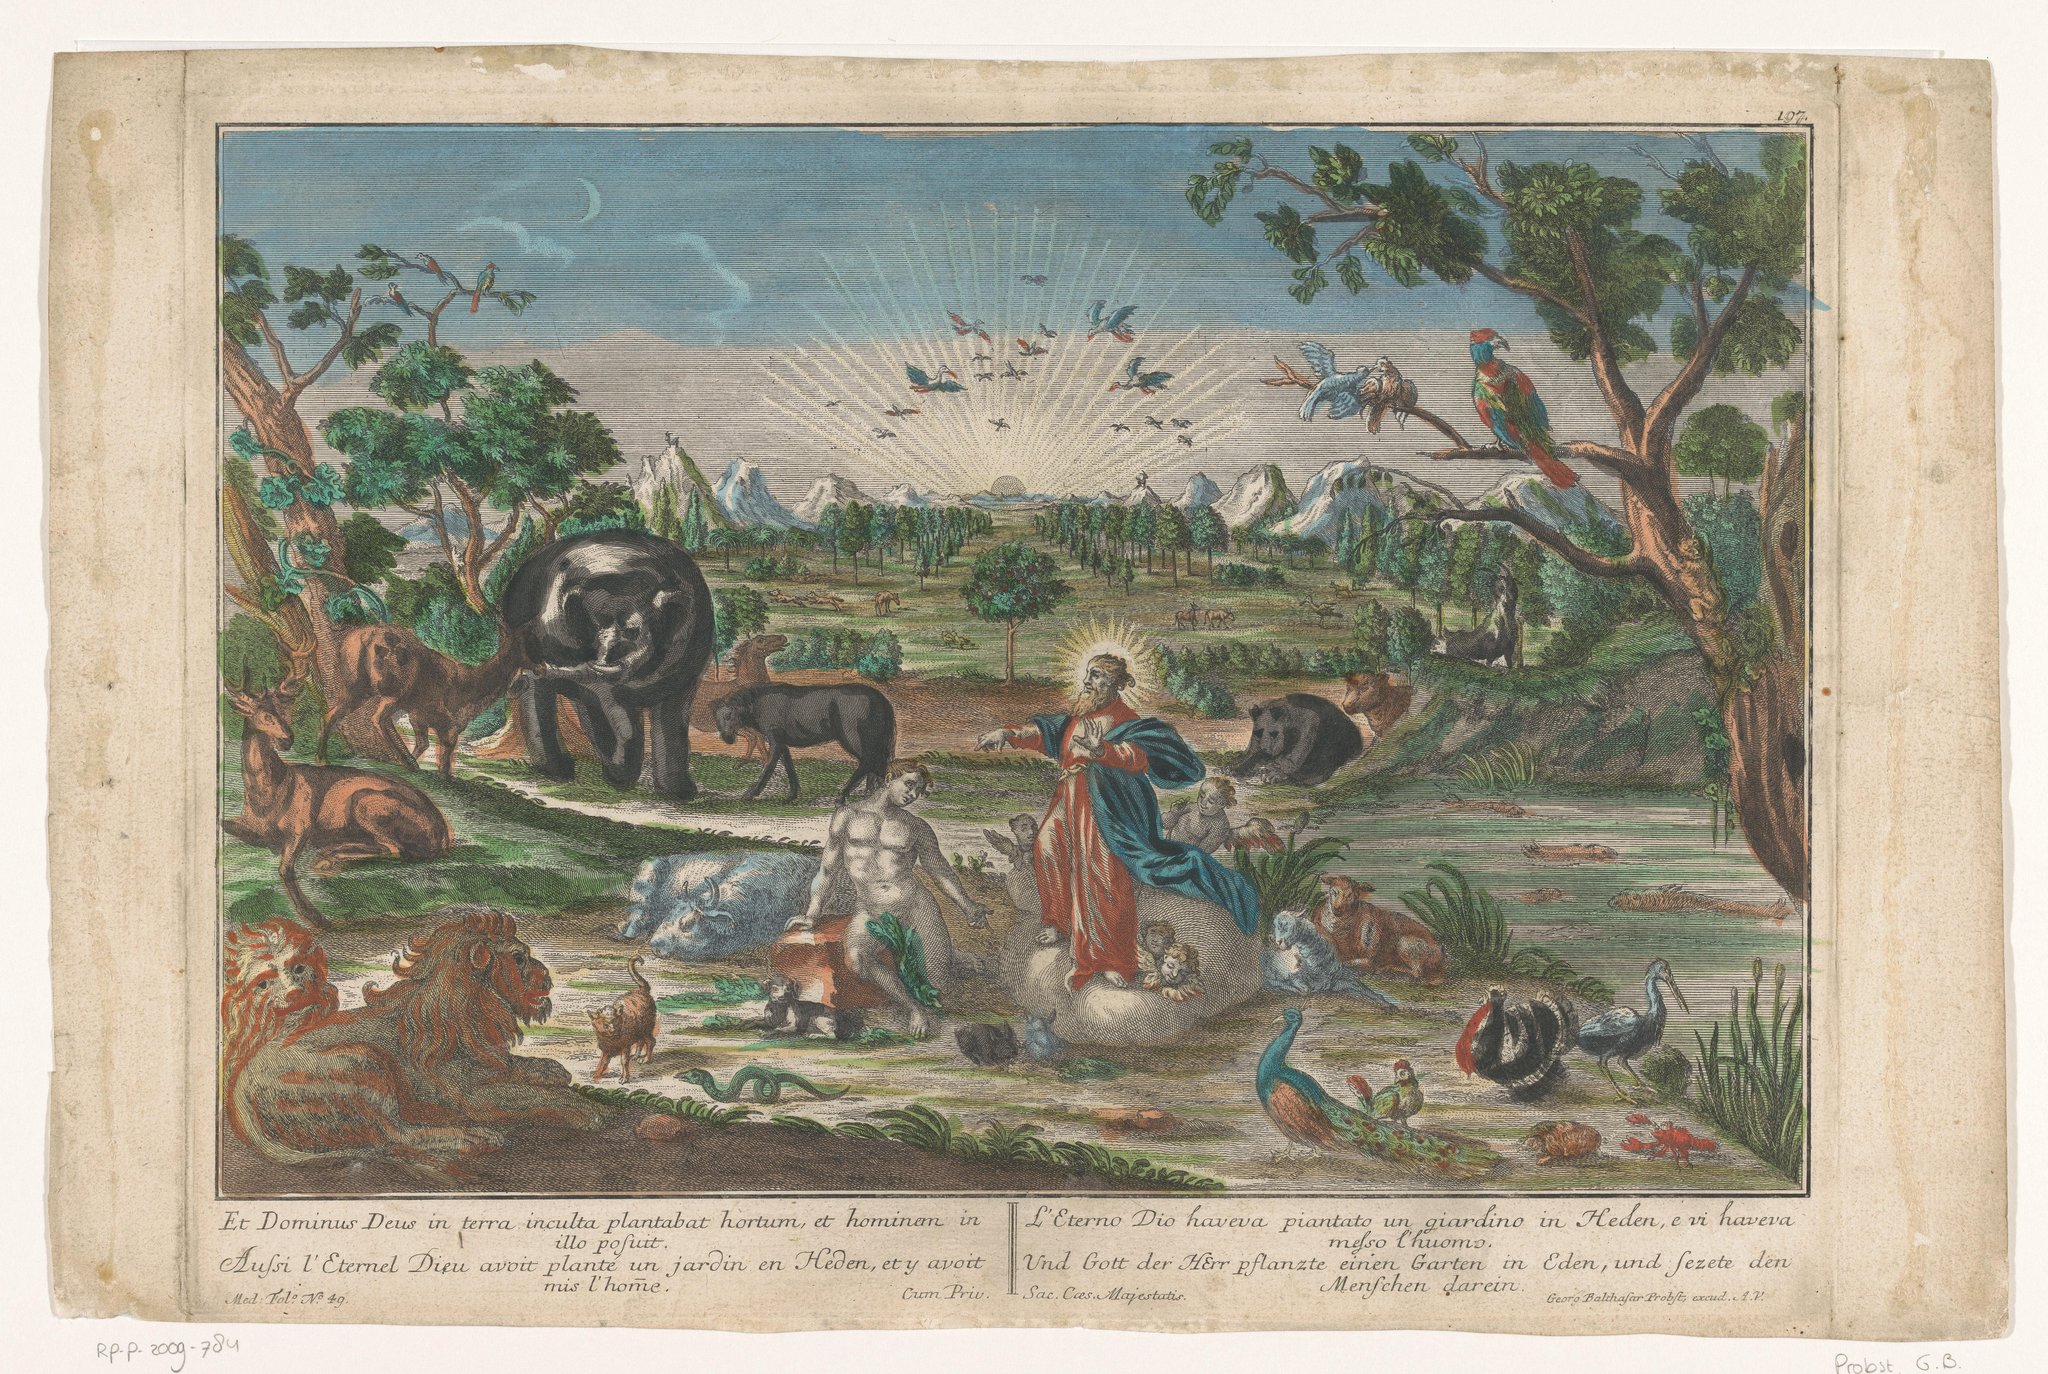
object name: print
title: Und Gott der Herr pflanzte einen Garten in Eden, und sezete den Menschen darein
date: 1742-1801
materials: paper, watercolor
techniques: brush, etching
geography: germany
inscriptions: collector's mark: Lugt 2228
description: In een weids landschap bij zonsopgang, met veel vogels en andere dieren, staat God op een wolk naast Adam. Onder de afbeelding de titel in vier talen.